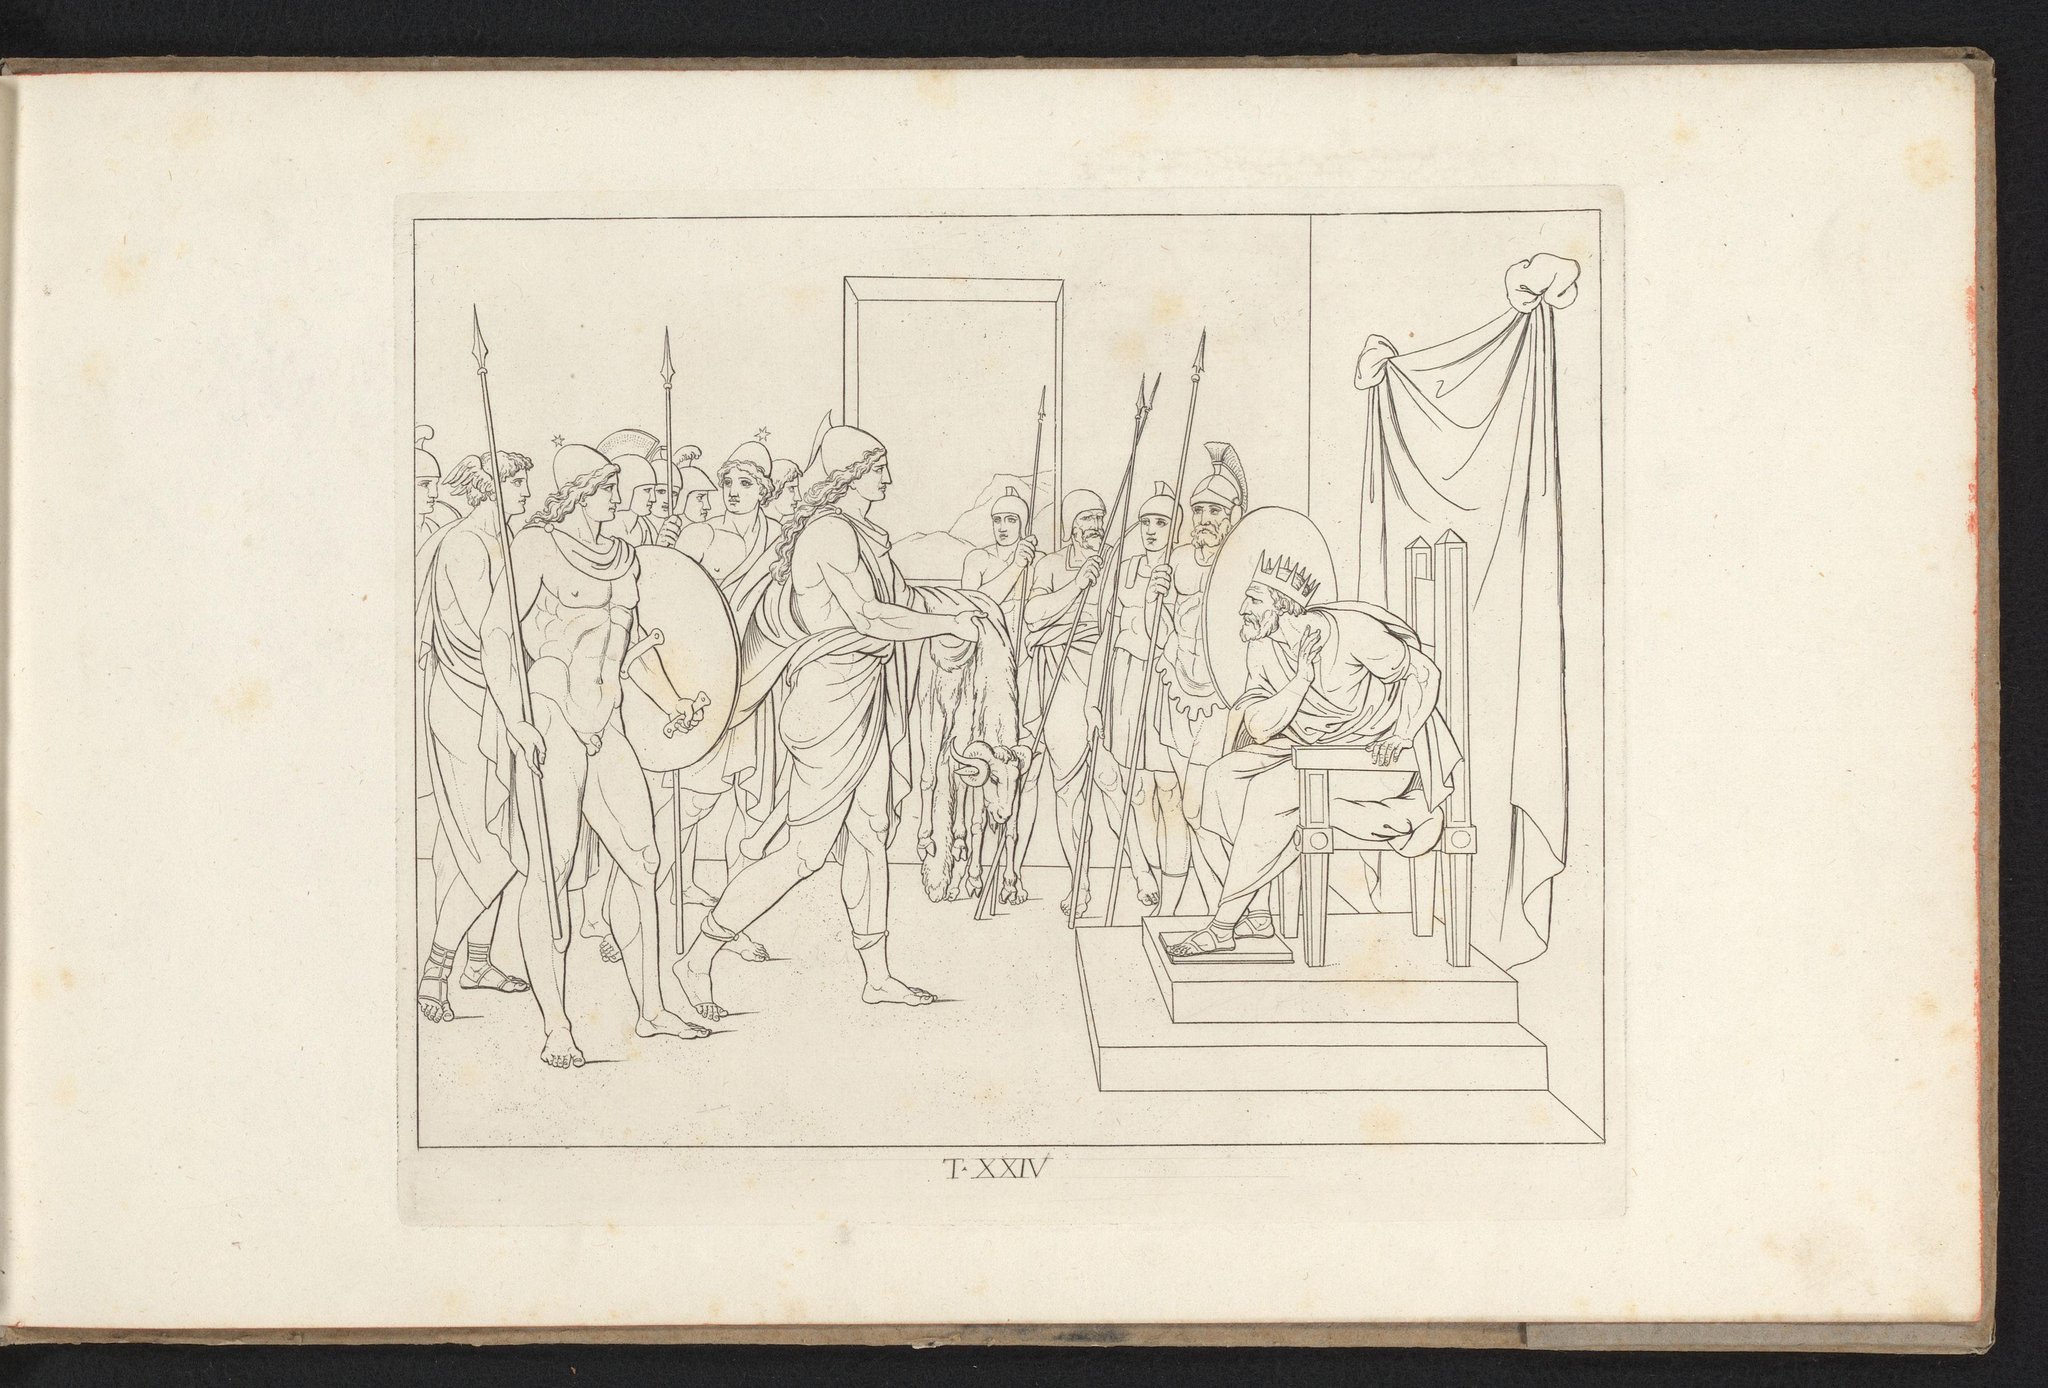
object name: album leaf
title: Jason en de Argonauten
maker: joseph anton koch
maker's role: draughtsman, painter, print maker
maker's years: 1768-1839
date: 1799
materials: paper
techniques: etching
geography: rome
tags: the story of the argonauts: the quest for the golden fleece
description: Deze prent maakt deel uit van een serie met 24 prenten.